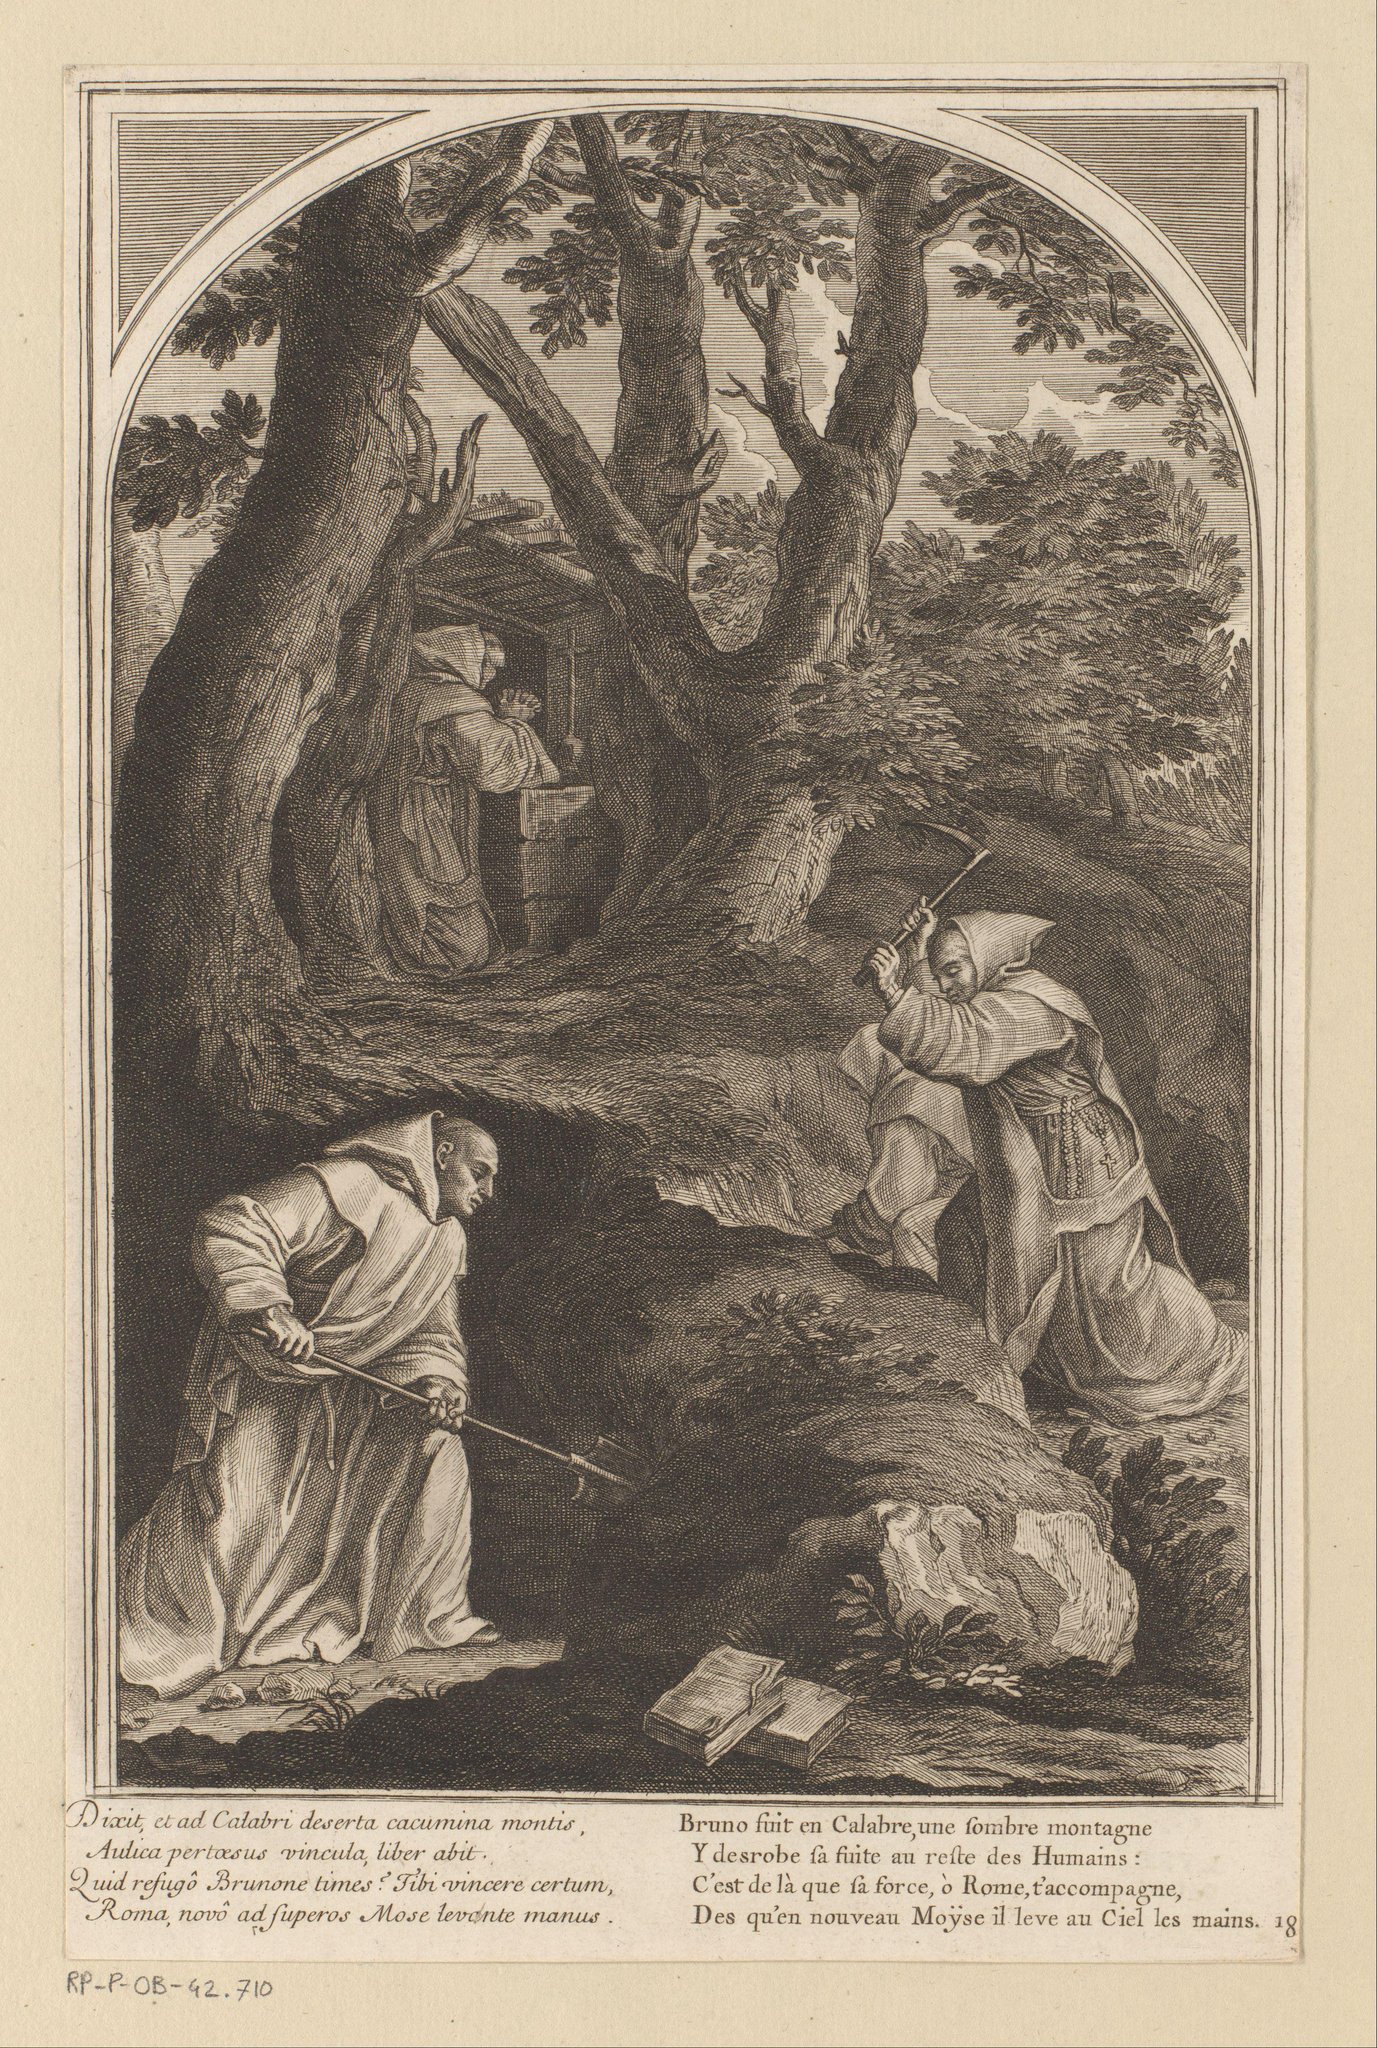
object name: print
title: Heilige Bruno in gebed in Calabrië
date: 1623-1676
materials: paper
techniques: engraving, etching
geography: france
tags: the founder of the order of the carthusians, bruno; possible attributes: cross, finger at lips, lily, mitre at his feet, olive-branch, ray of light, skull, (seven) star(s), personal devotion of st. bruno - male saint meditating, in ecstasy, calabria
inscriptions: collector's mark: Lugt 2165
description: Maakt deel uit van een serie met 24 prenten (inclusief twee titelprenten), naar schilderijen door Lesueur vervaardigd tussen 1645-1648 voor de Chartreuse de Paris. De serie is getiteld: La vie de St. Bruno fondateur de l'Ordre des Chartreux peinte au cloistre de la Chartreuse de Paris par Eustache Le Sueur.